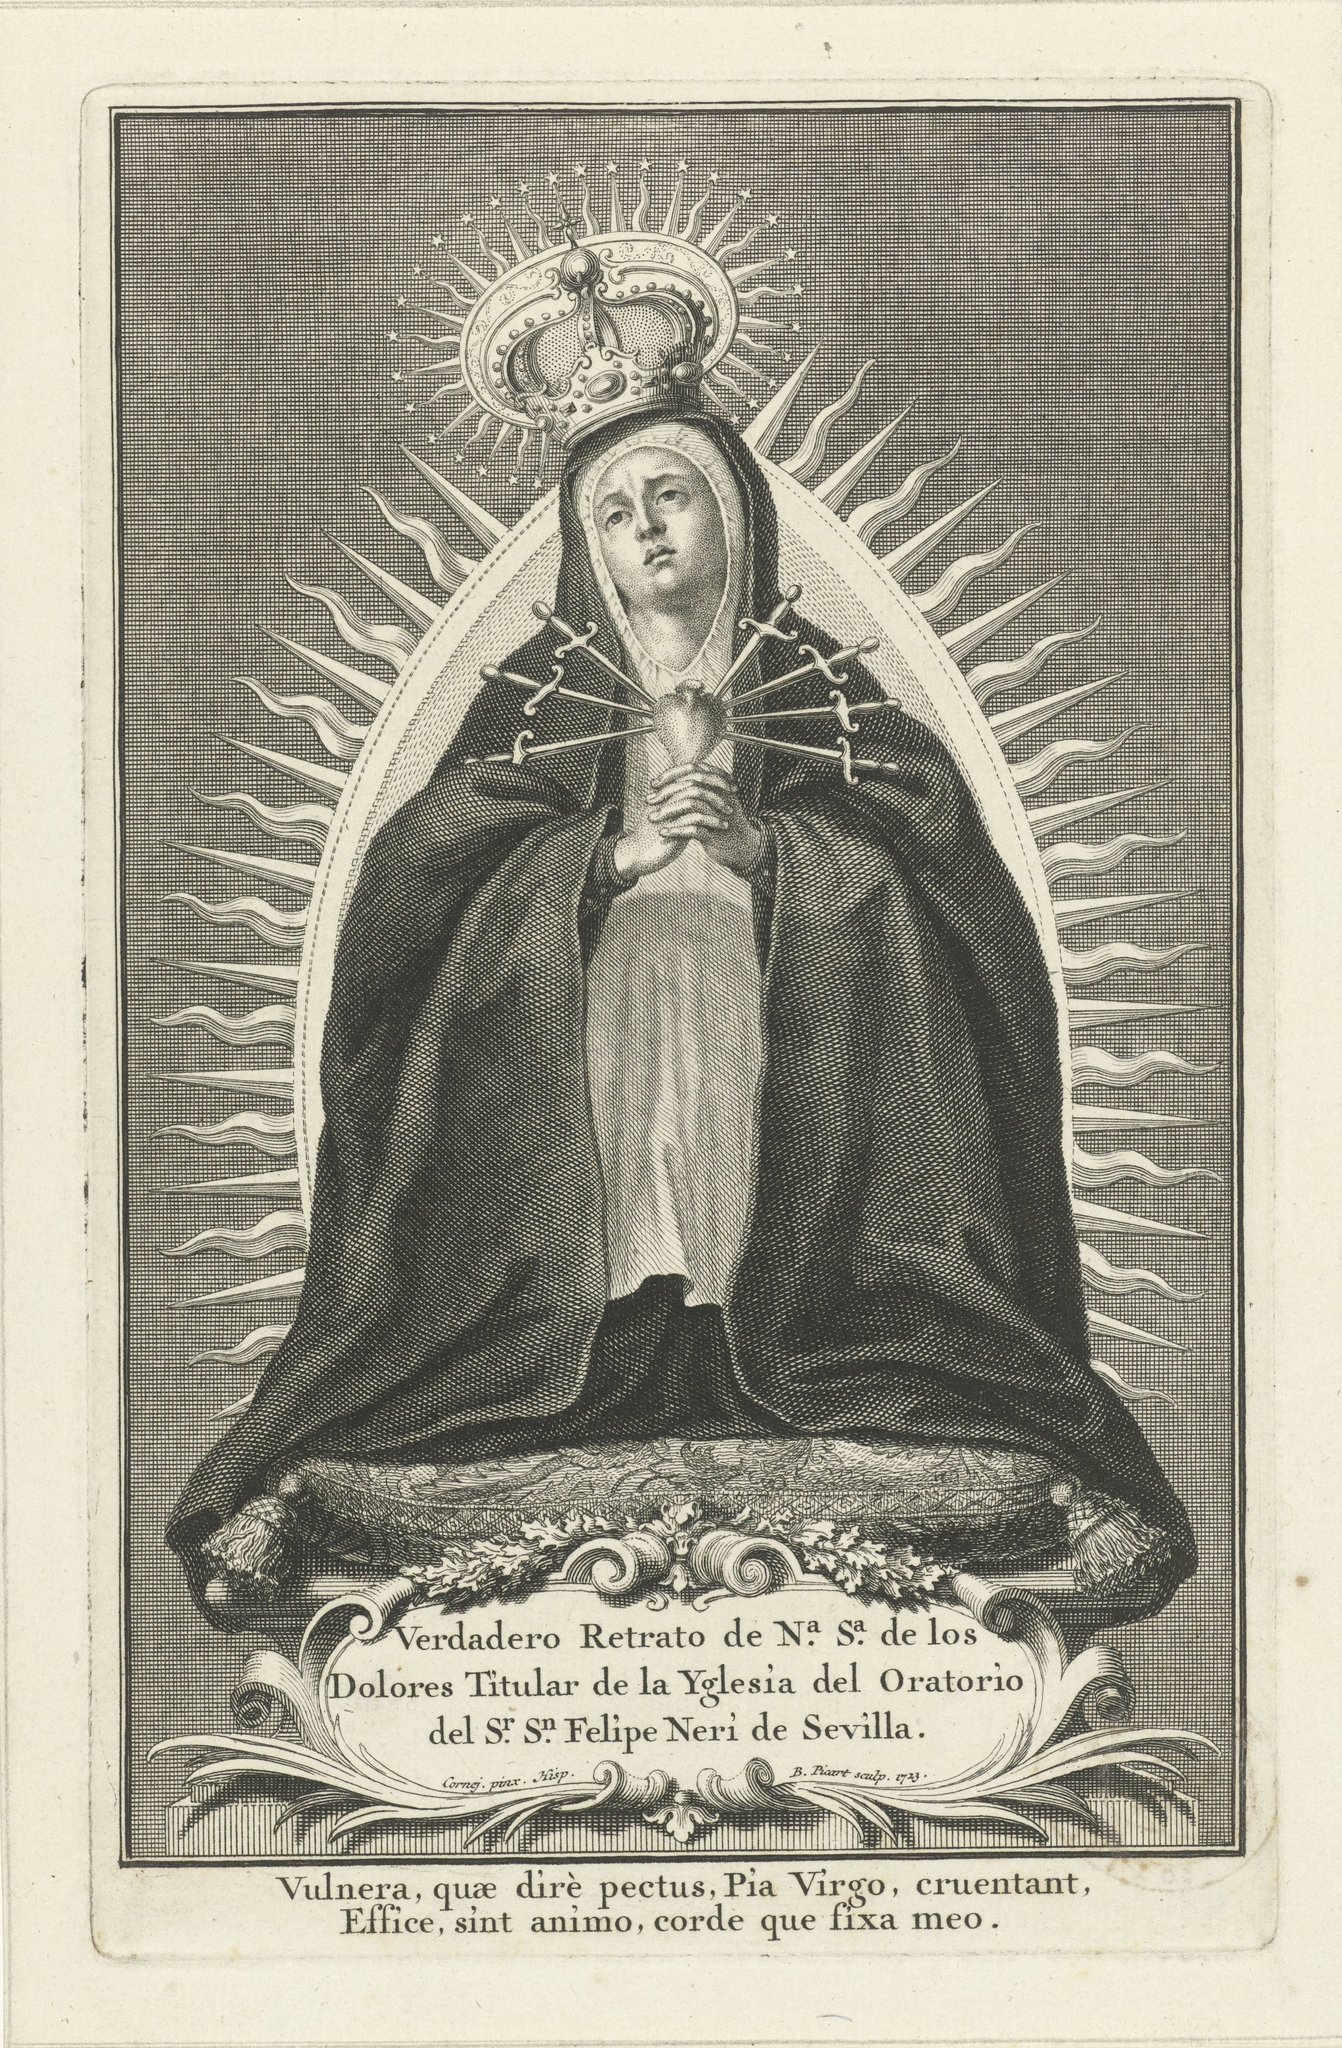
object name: print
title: Maria als Mater Dolorosa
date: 1723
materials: paper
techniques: engraving, etching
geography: amsterdam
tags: rome, mary pierced by seven swords, sevilla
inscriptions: collector's mark: Lugt 240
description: Maria als Mater Dolorosa. Ze houdt een met zeven zwaarden doorboord hart vast dat verwijst naar de Zeven Smarten. In de cartouche een verwijzing naar het klooster San Felipe Neri te Sevilla. In de marge een tweeregelig onderschrift in het Latijn.